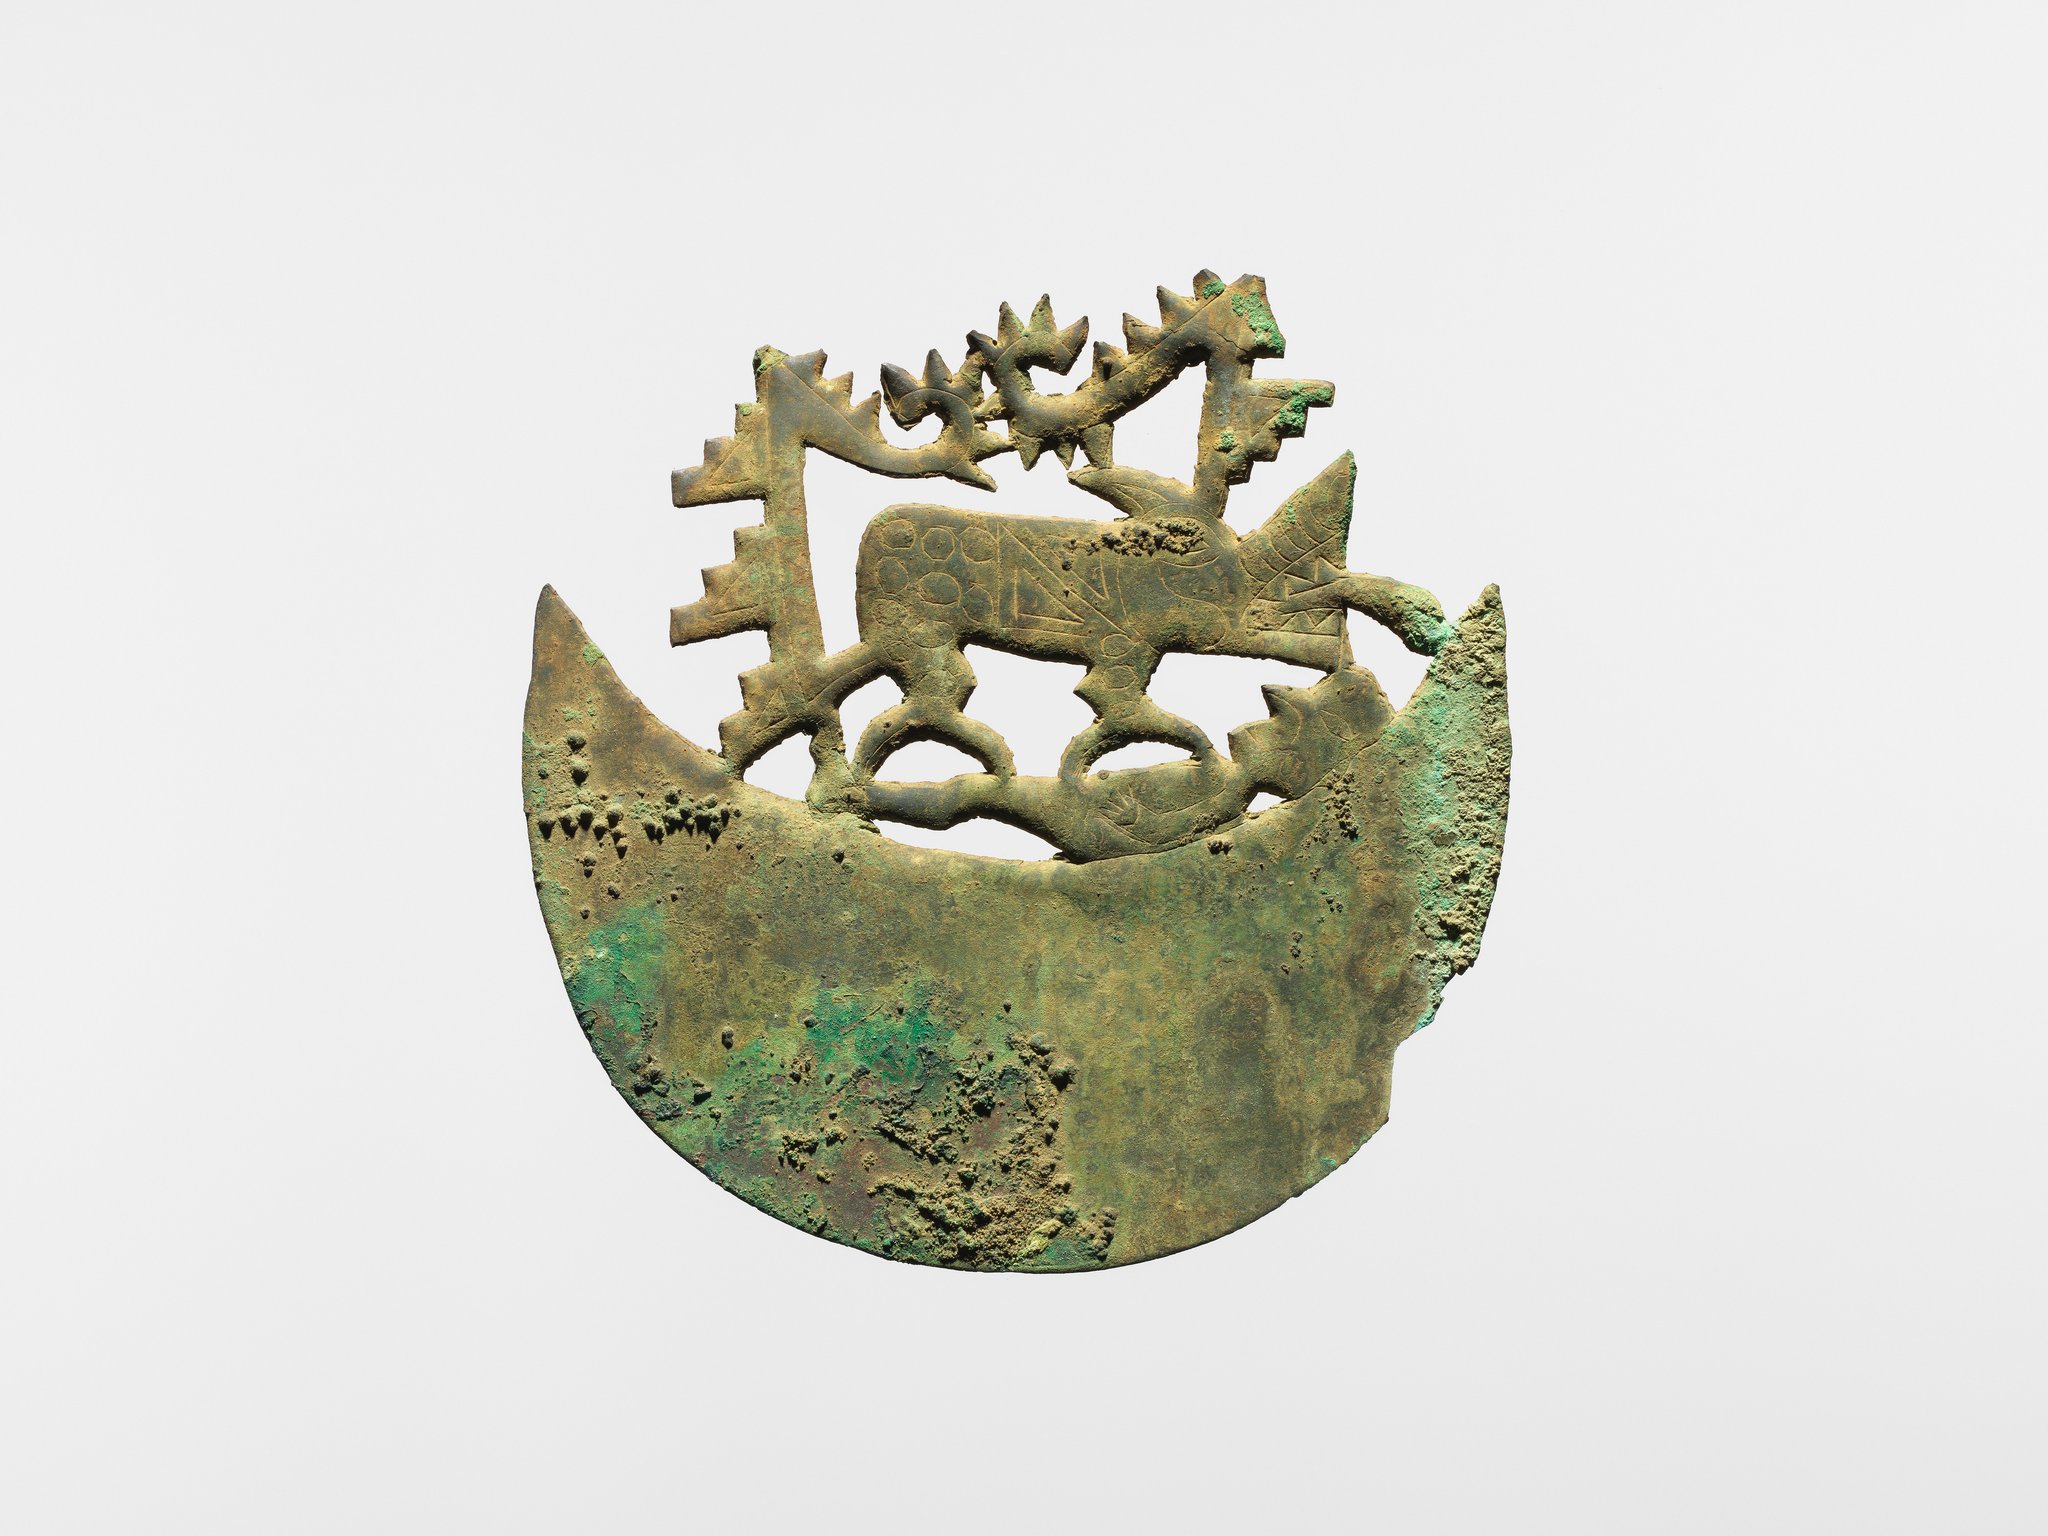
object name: ornament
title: Animal Ornament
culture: moche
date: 501-700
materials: copper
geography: peru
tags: animals